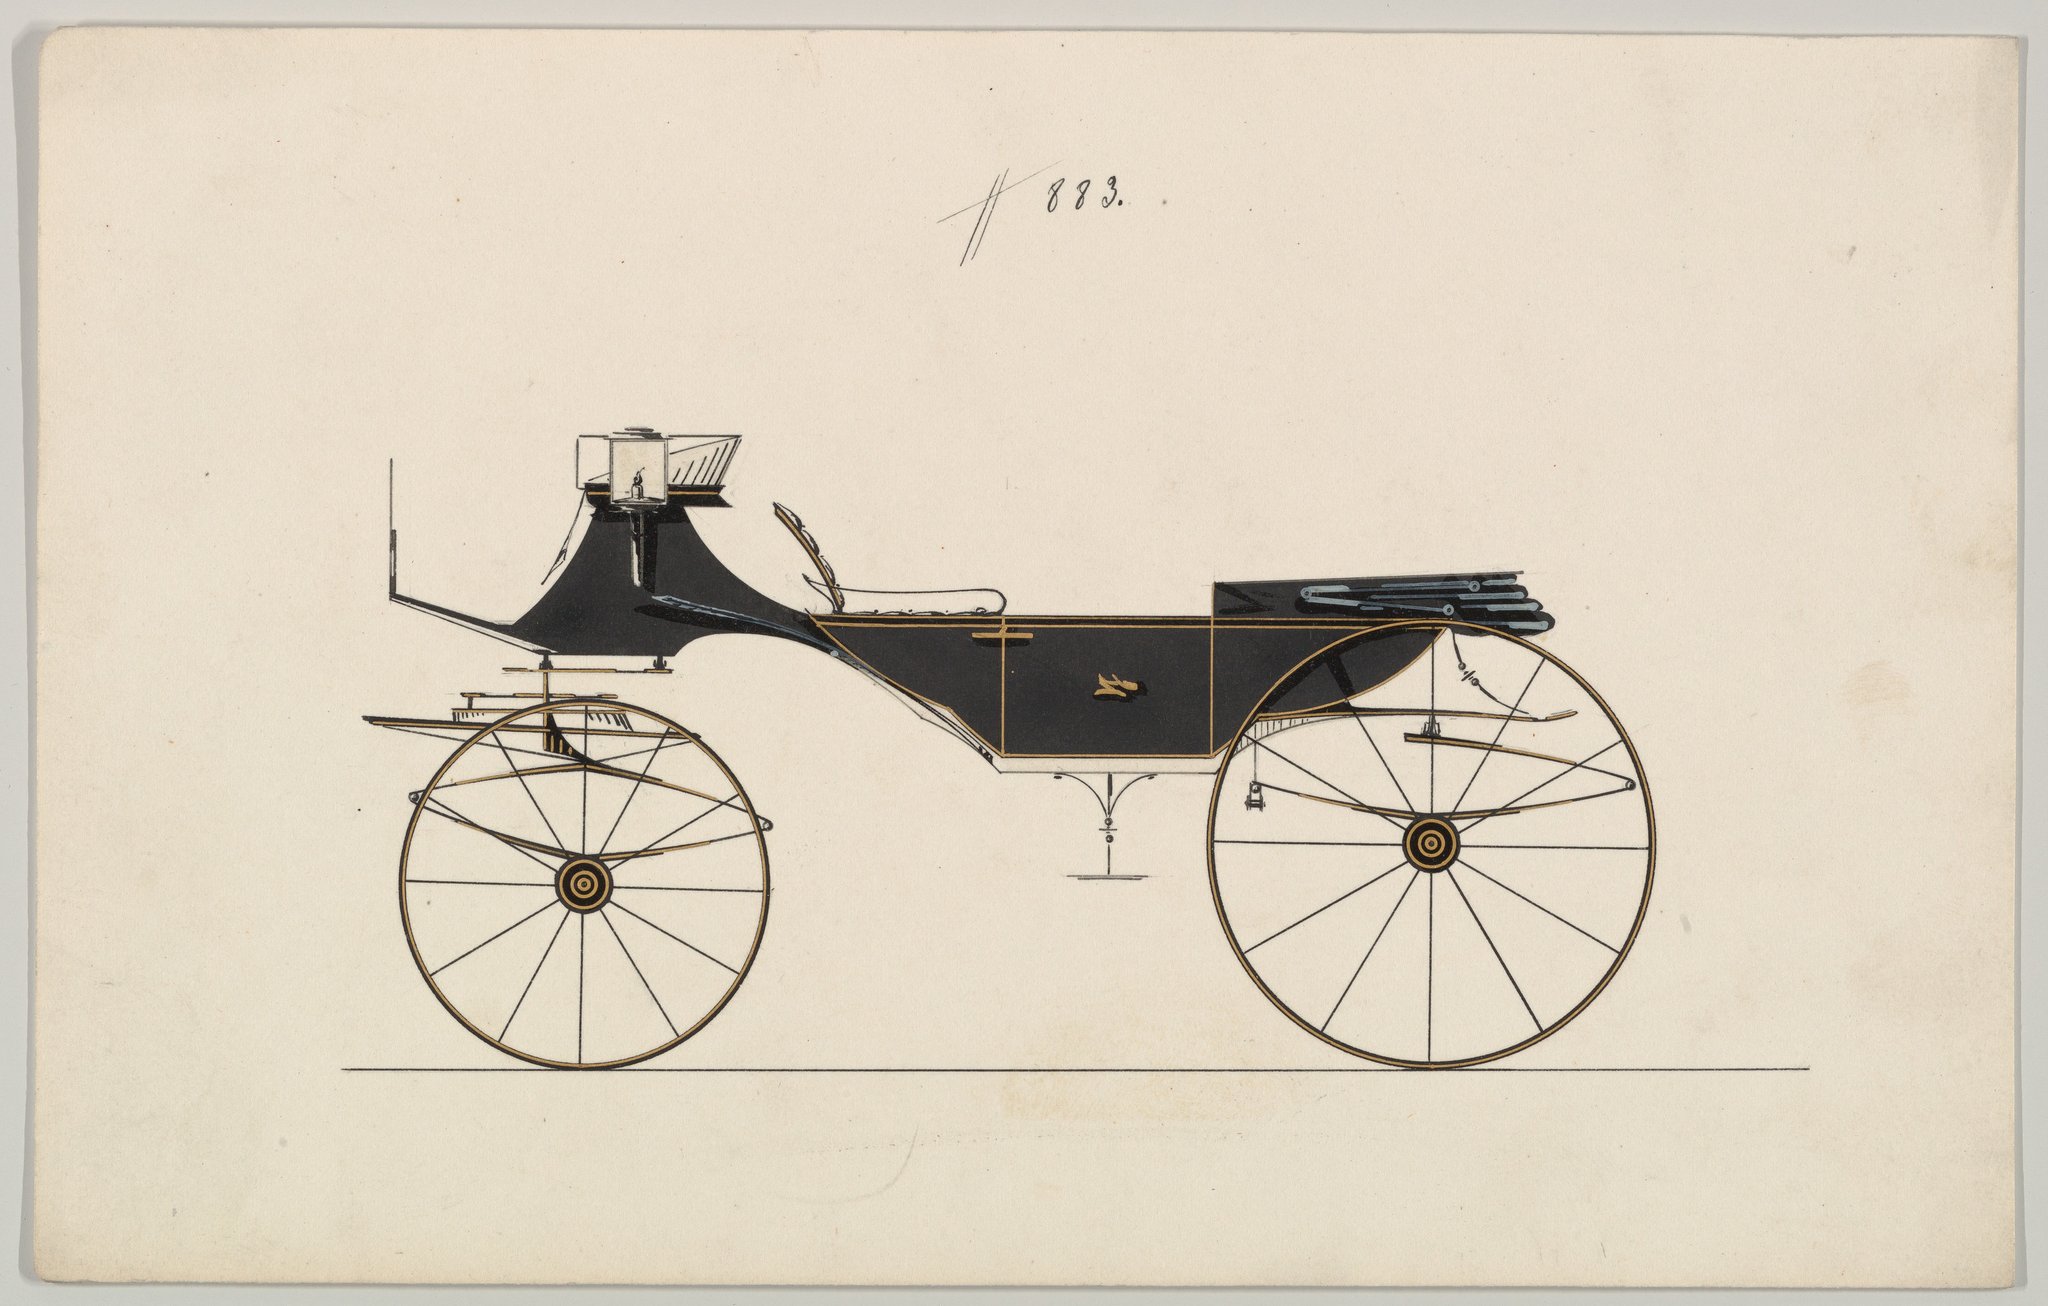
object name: drawing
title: Design for Vis-à-vis, no. 883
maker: brewster & co.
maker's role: manufacturer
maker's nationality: american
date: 1850-1870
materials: gouache, graphite, gum arabic, ink, watercolor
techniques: pen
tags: carriages